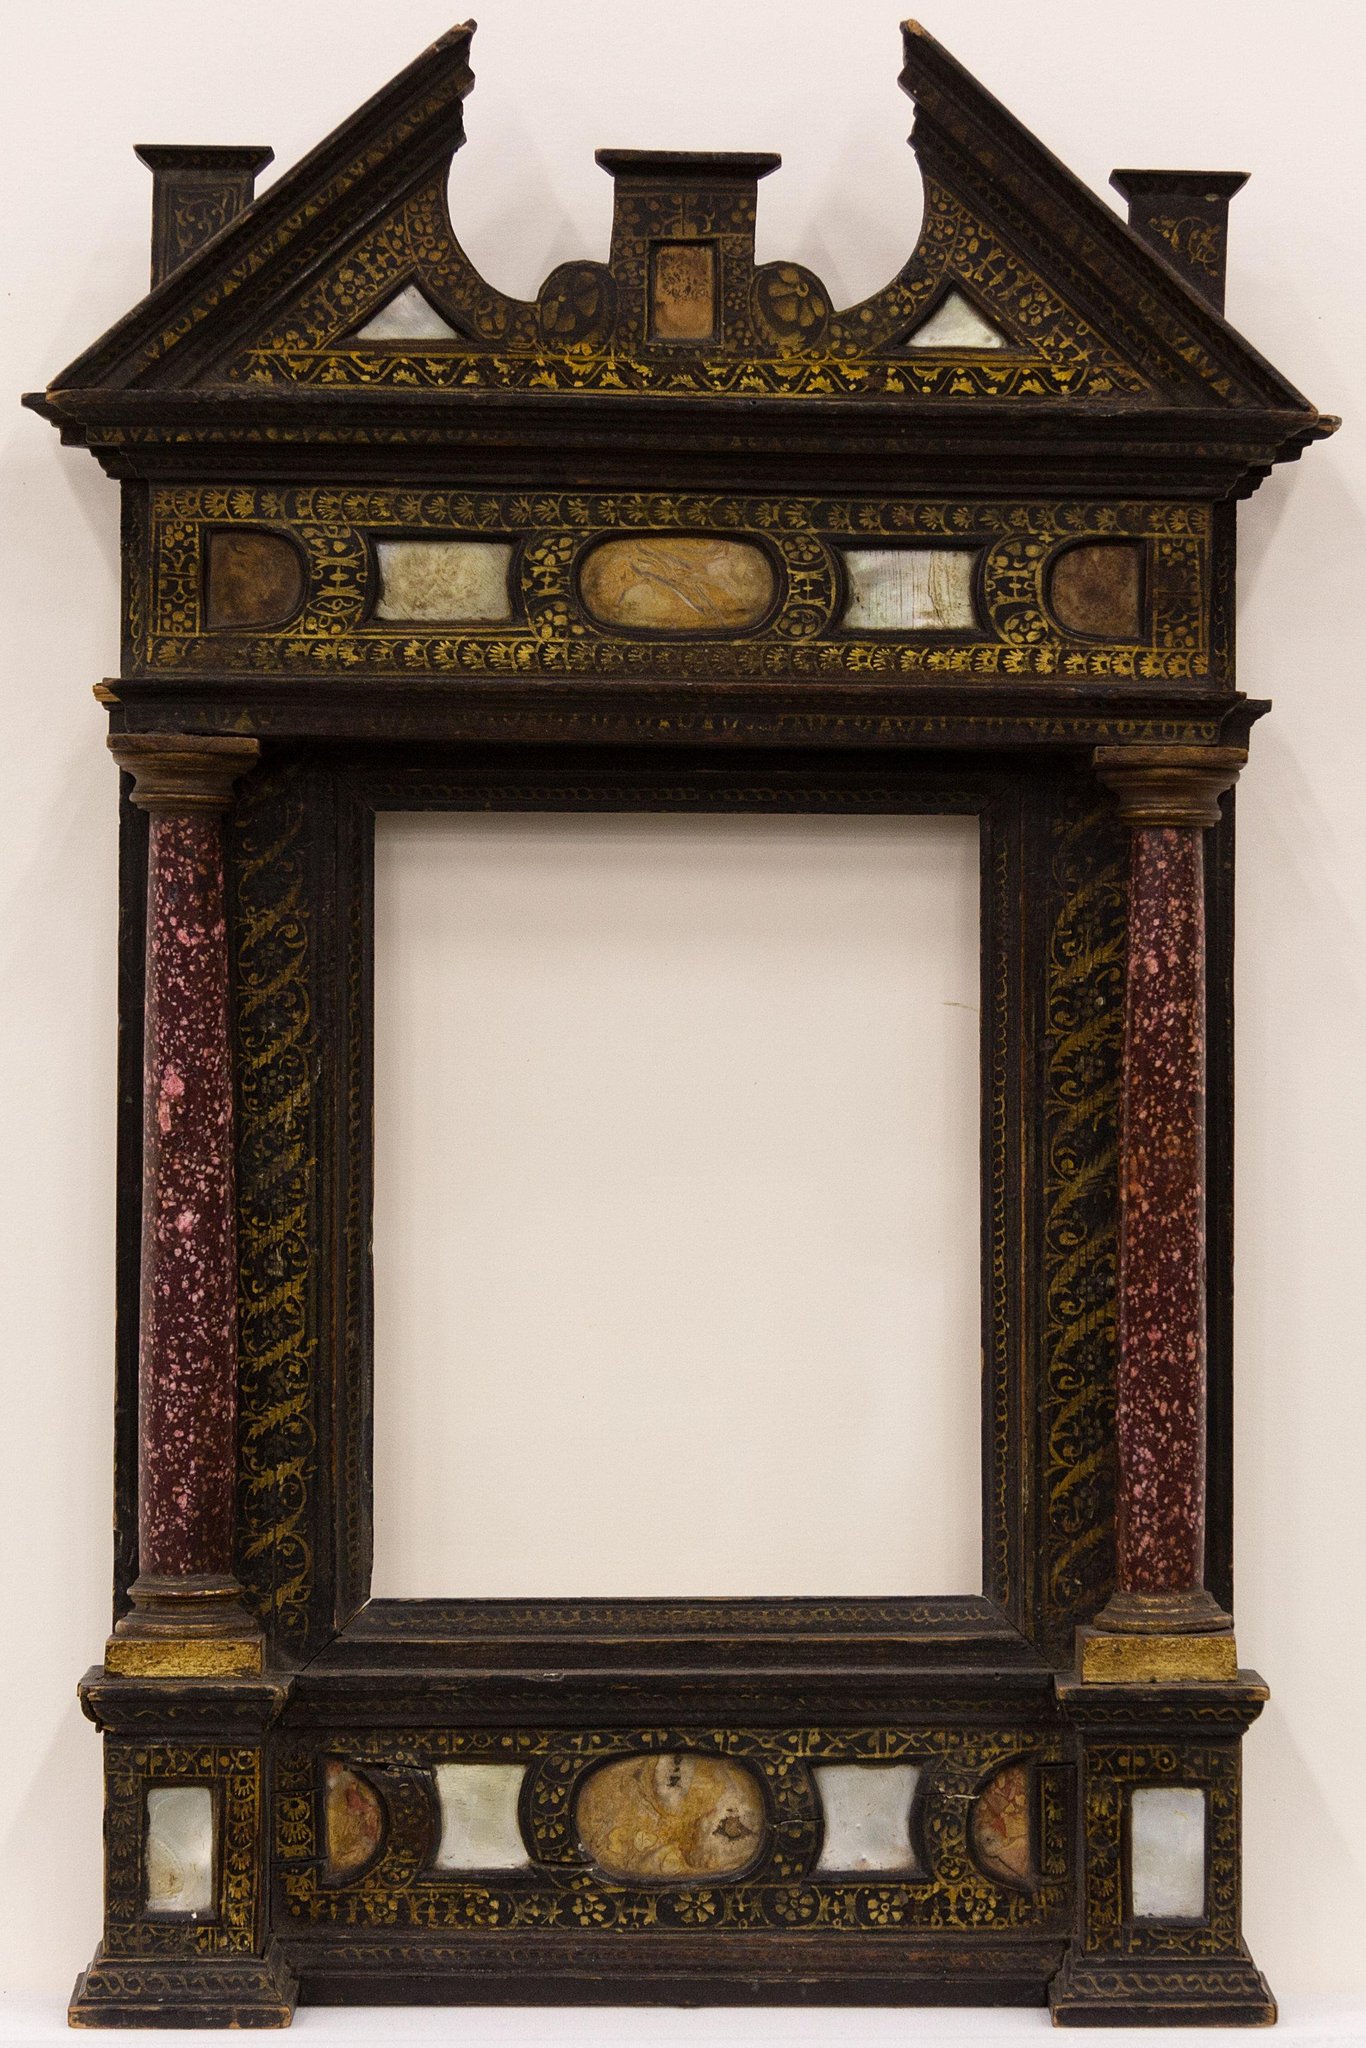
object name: frame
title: Italiaanse vergulde, gesneden en gemarmerde tabernakellijst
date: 1550-1599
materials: marble, wood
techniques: cutting, painting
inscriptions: label: ‘EX LIBRIS // E. RODRIGUES’, label: ‘42’, annotation: ‘K O E N I G S’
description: De tabernakellijst, van zwart geverfd hout met kleine eenvoudige ornamentjes, heeft een onderbroken pediment waarin zes stukken marmer zijn ingelegd. Links en rechts een marmeren pilaar en een onderstel waarin vier rechthoeken en drie ovalen van marmer zijn opgenomen. De lijst bevat een perspex plaatje. Voor sterk gelijkende lijsten zie RP-L-110 en SK-L-3939.